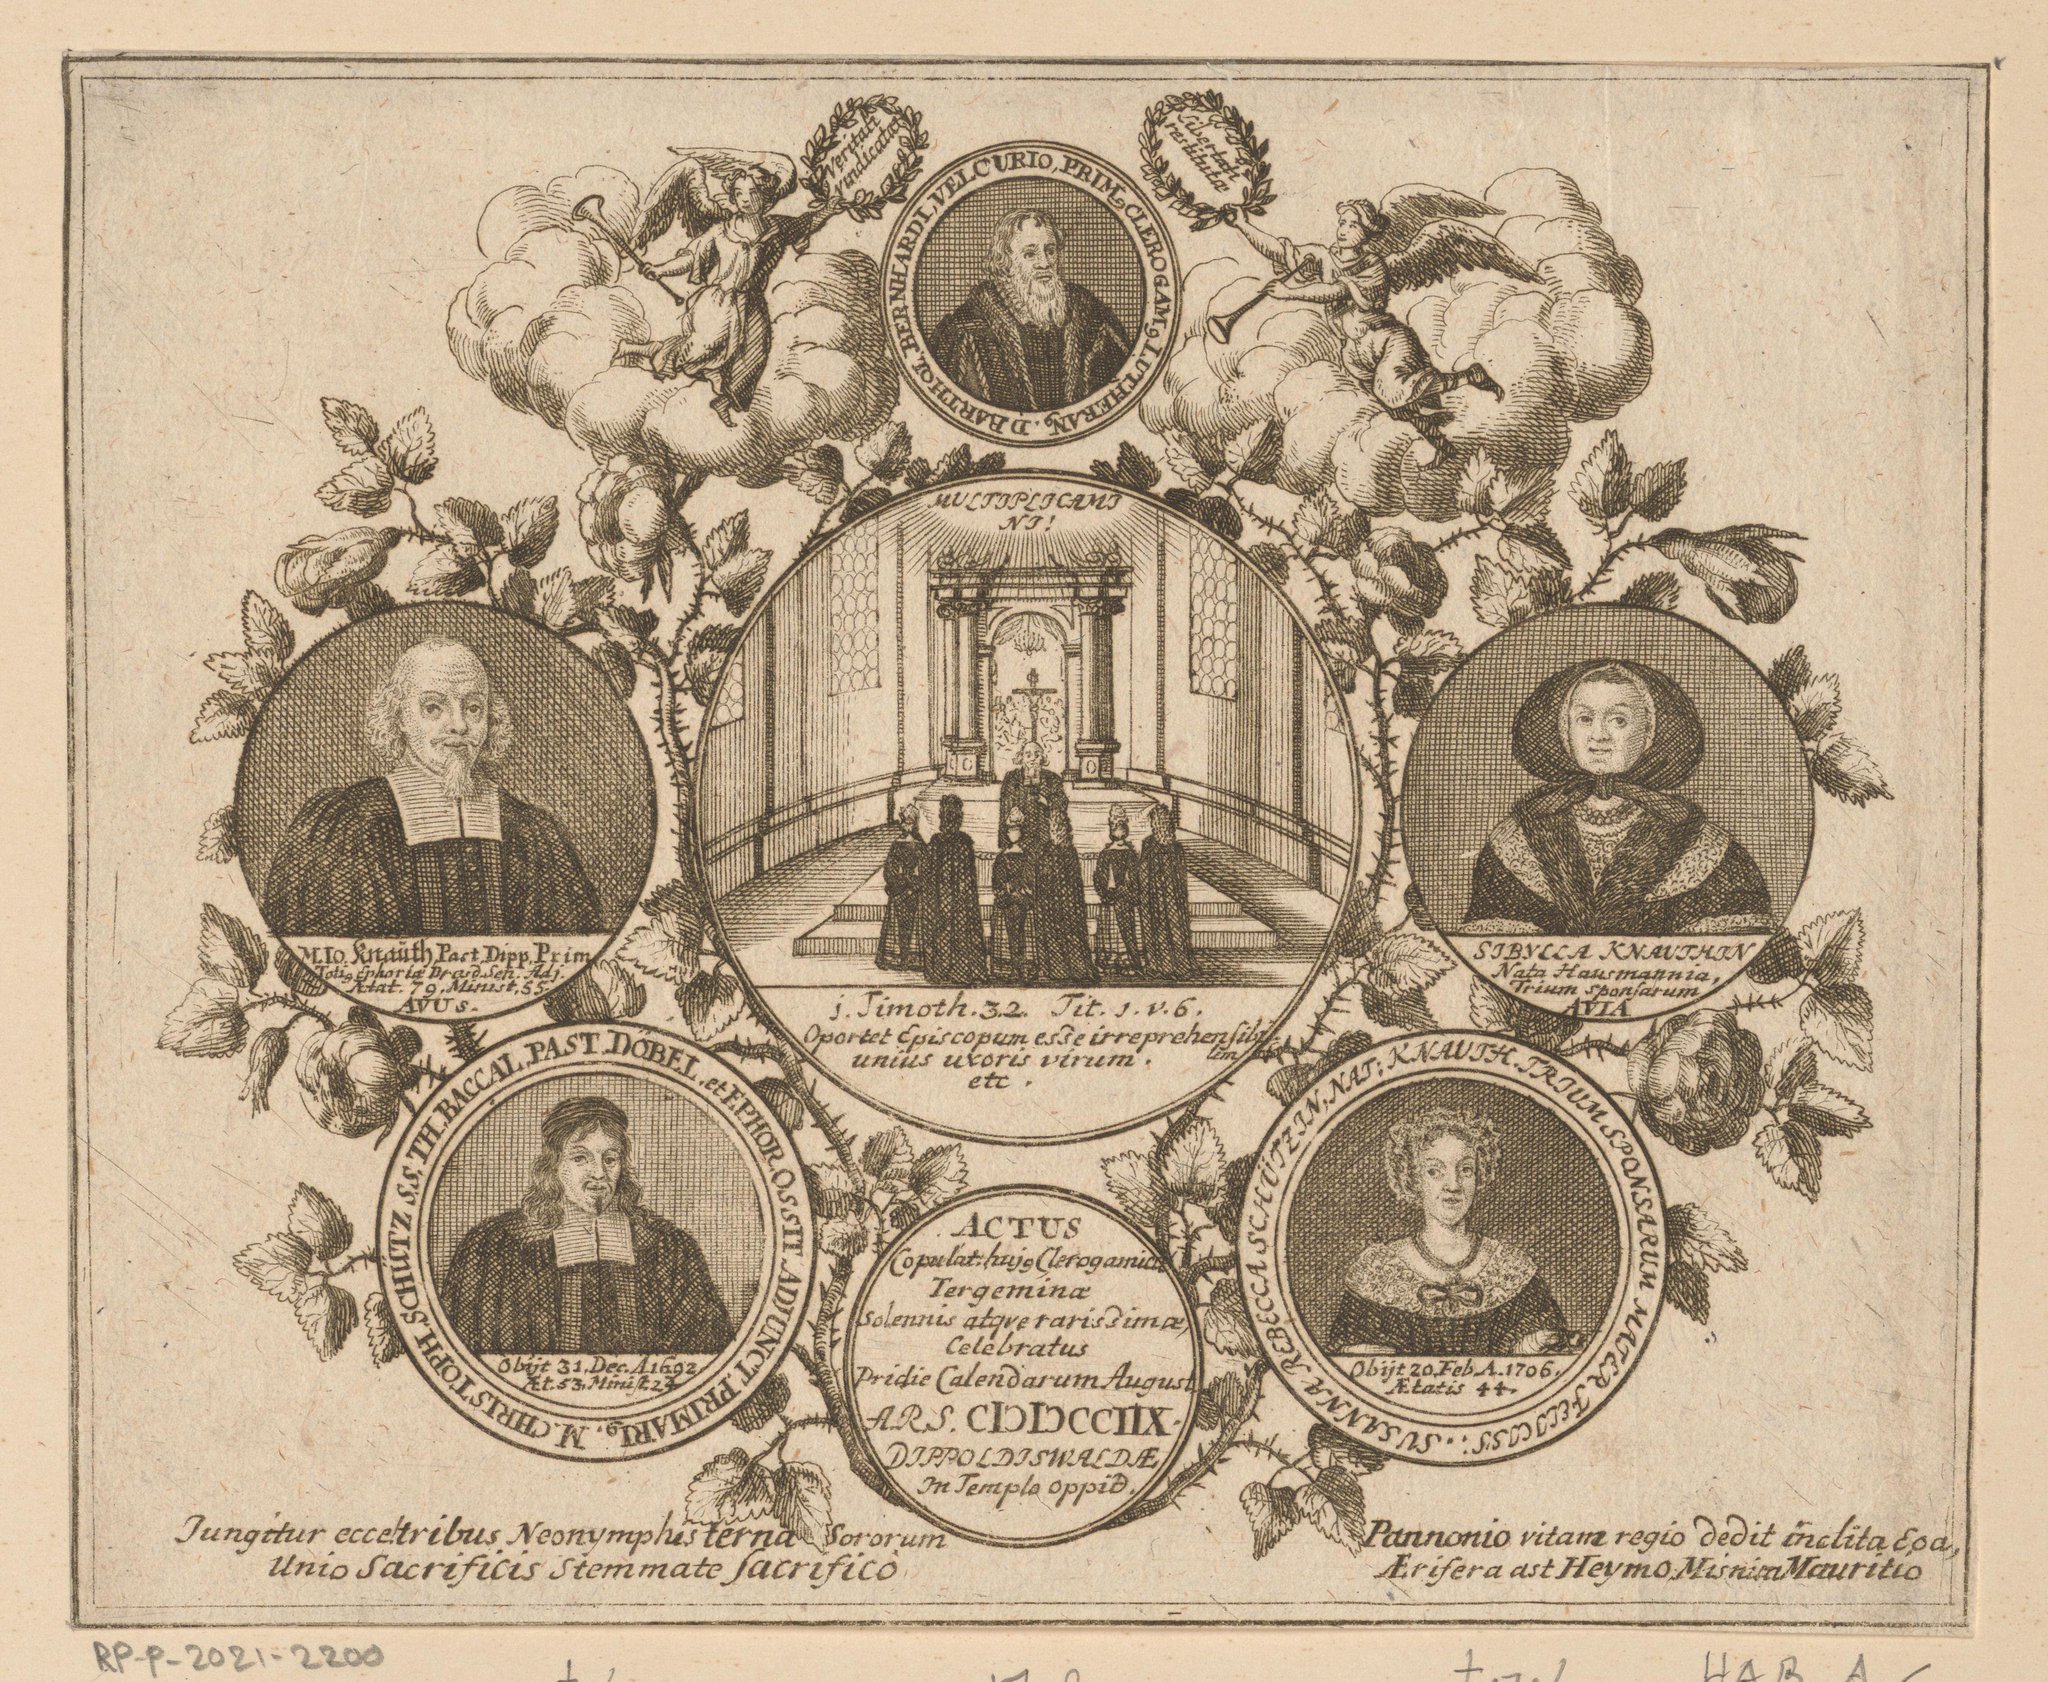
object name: print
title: Portretten van Johann Knauth, Sibylle Knauth, Christoph Schütz en Maria Elisabeth Schütze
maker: Anonymous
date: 1708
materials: paper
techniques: engraving, etching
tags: cologne, historical persons - bb - woman, historical persons, bible (+ angel(s) floating in the air), flowers: rose, sermon ~ holy mass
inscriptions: date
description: De portretten worden aan elkaar verbonden door een rozenstruik. Te midden van de portretten is Johann Knauth afgebeeld die een mis opvoert.